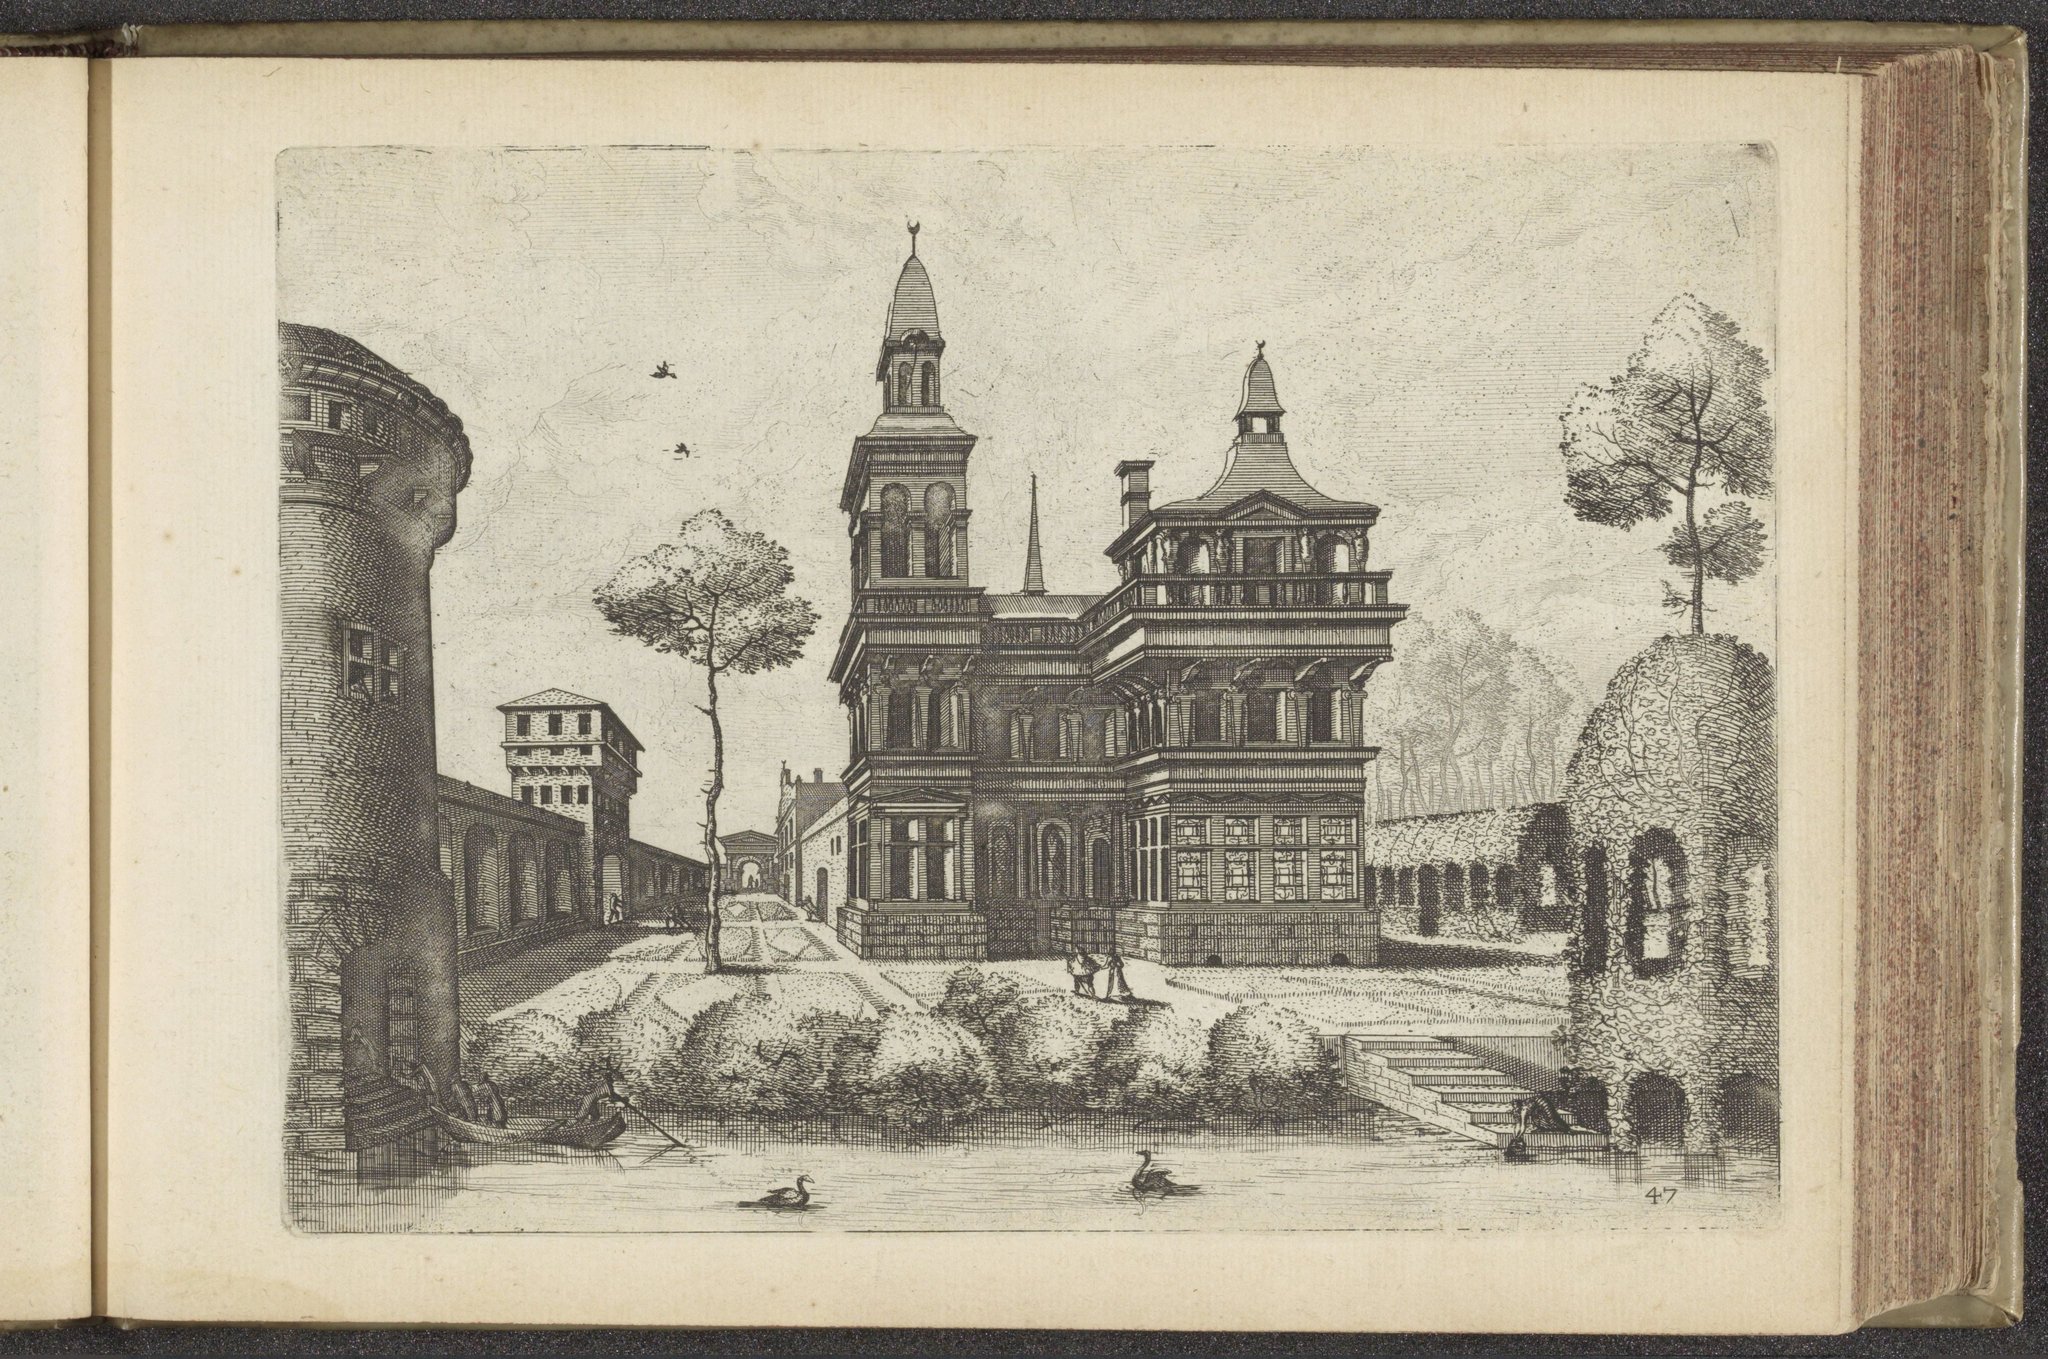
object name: album leaf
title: Variae Architecturae formae (...)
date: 1562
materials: paper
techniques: etching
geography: antwerp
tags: fortress, architectural representations in general, castle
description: Gezicht op een kasteel met links een vestingmuur. Rechts een gang van traliewerk en een paviljoen. Deze prent maakt deel uit van een album.